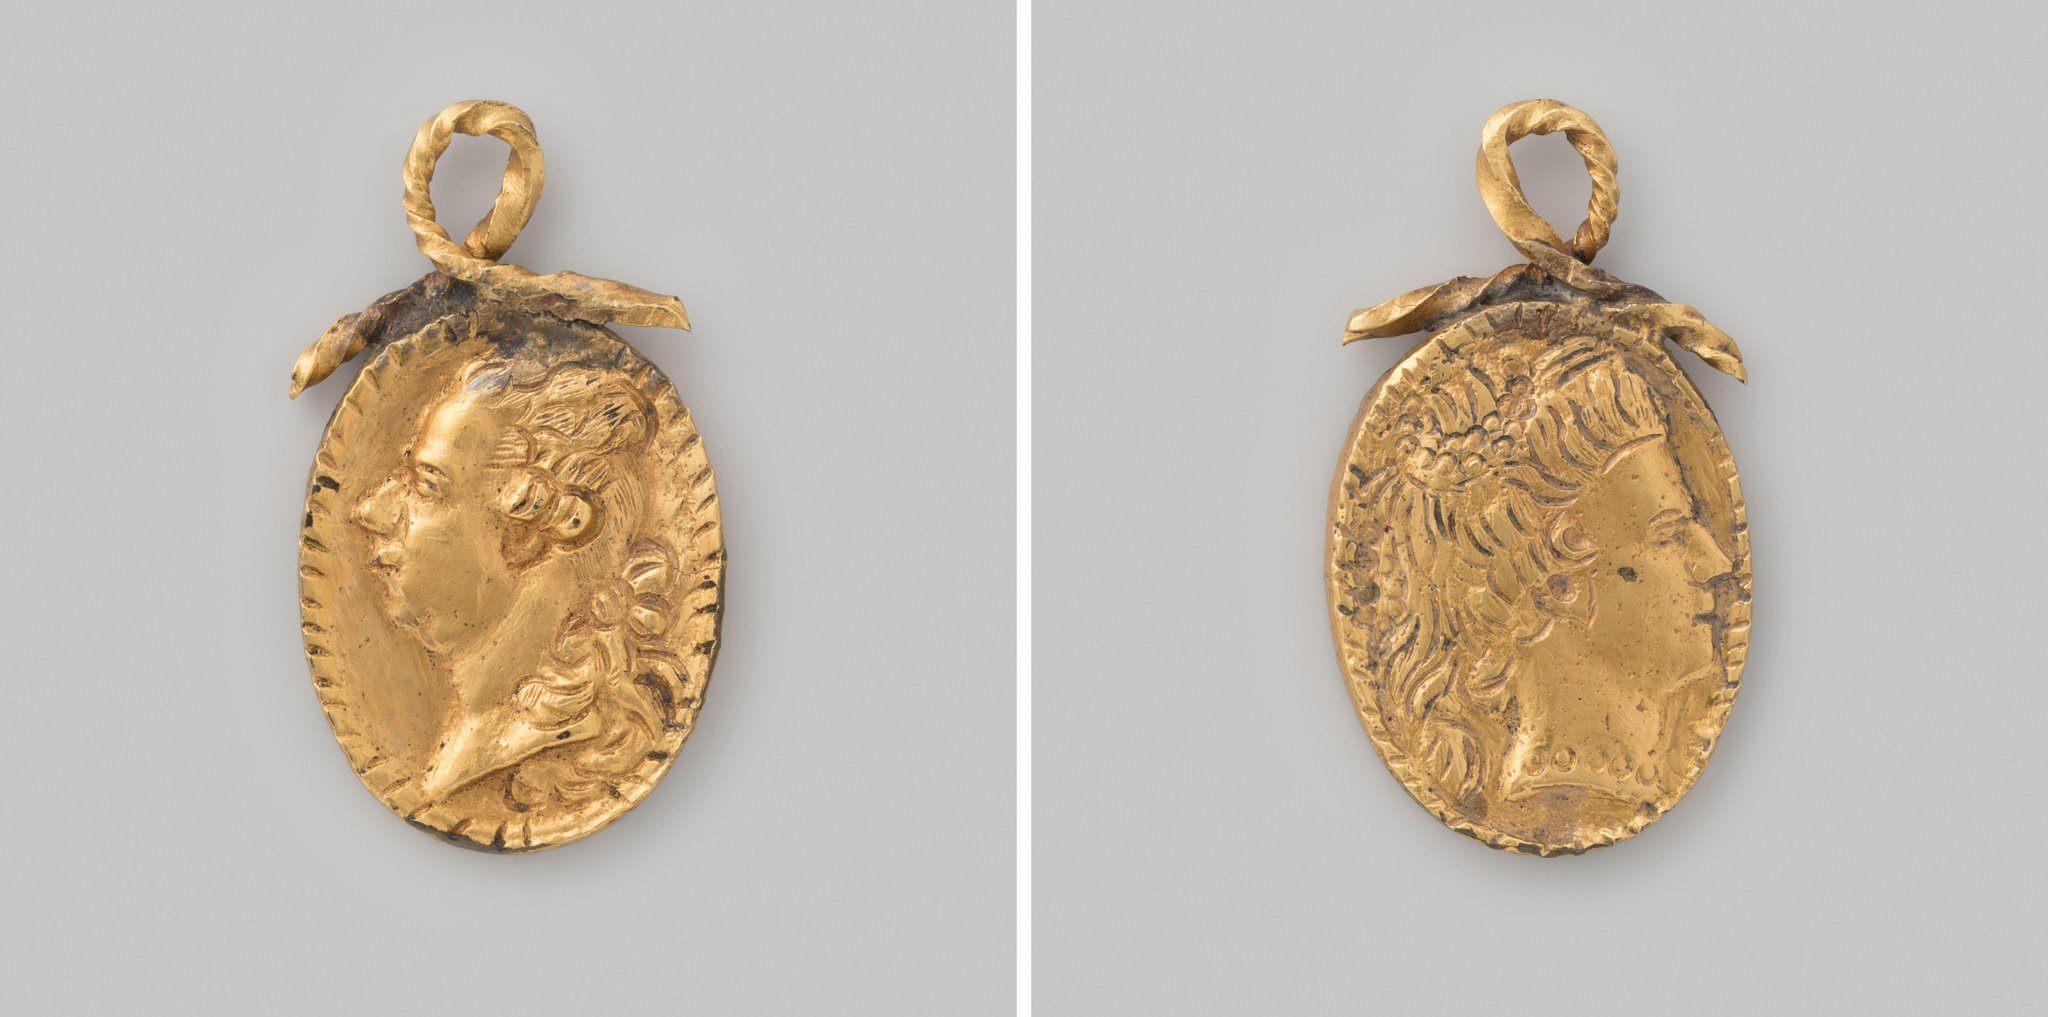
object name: insignia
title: Willem V en Wilhelmina van Pruisen, prins en prinses van Oranje-Nassau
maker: Anonymous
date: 1787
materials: copper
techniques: casting, gilding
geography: netherlands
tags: the hague, william v (prince of orange), berlin, draughtsman, wilhelmina of prussia (princess of orange)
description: Koperen ovaal draagteken aan strik. Voorzijde: borststuk man binnen gearceerde rand. Keerzijde: borststuk vrouw binnen gearceerde rand.